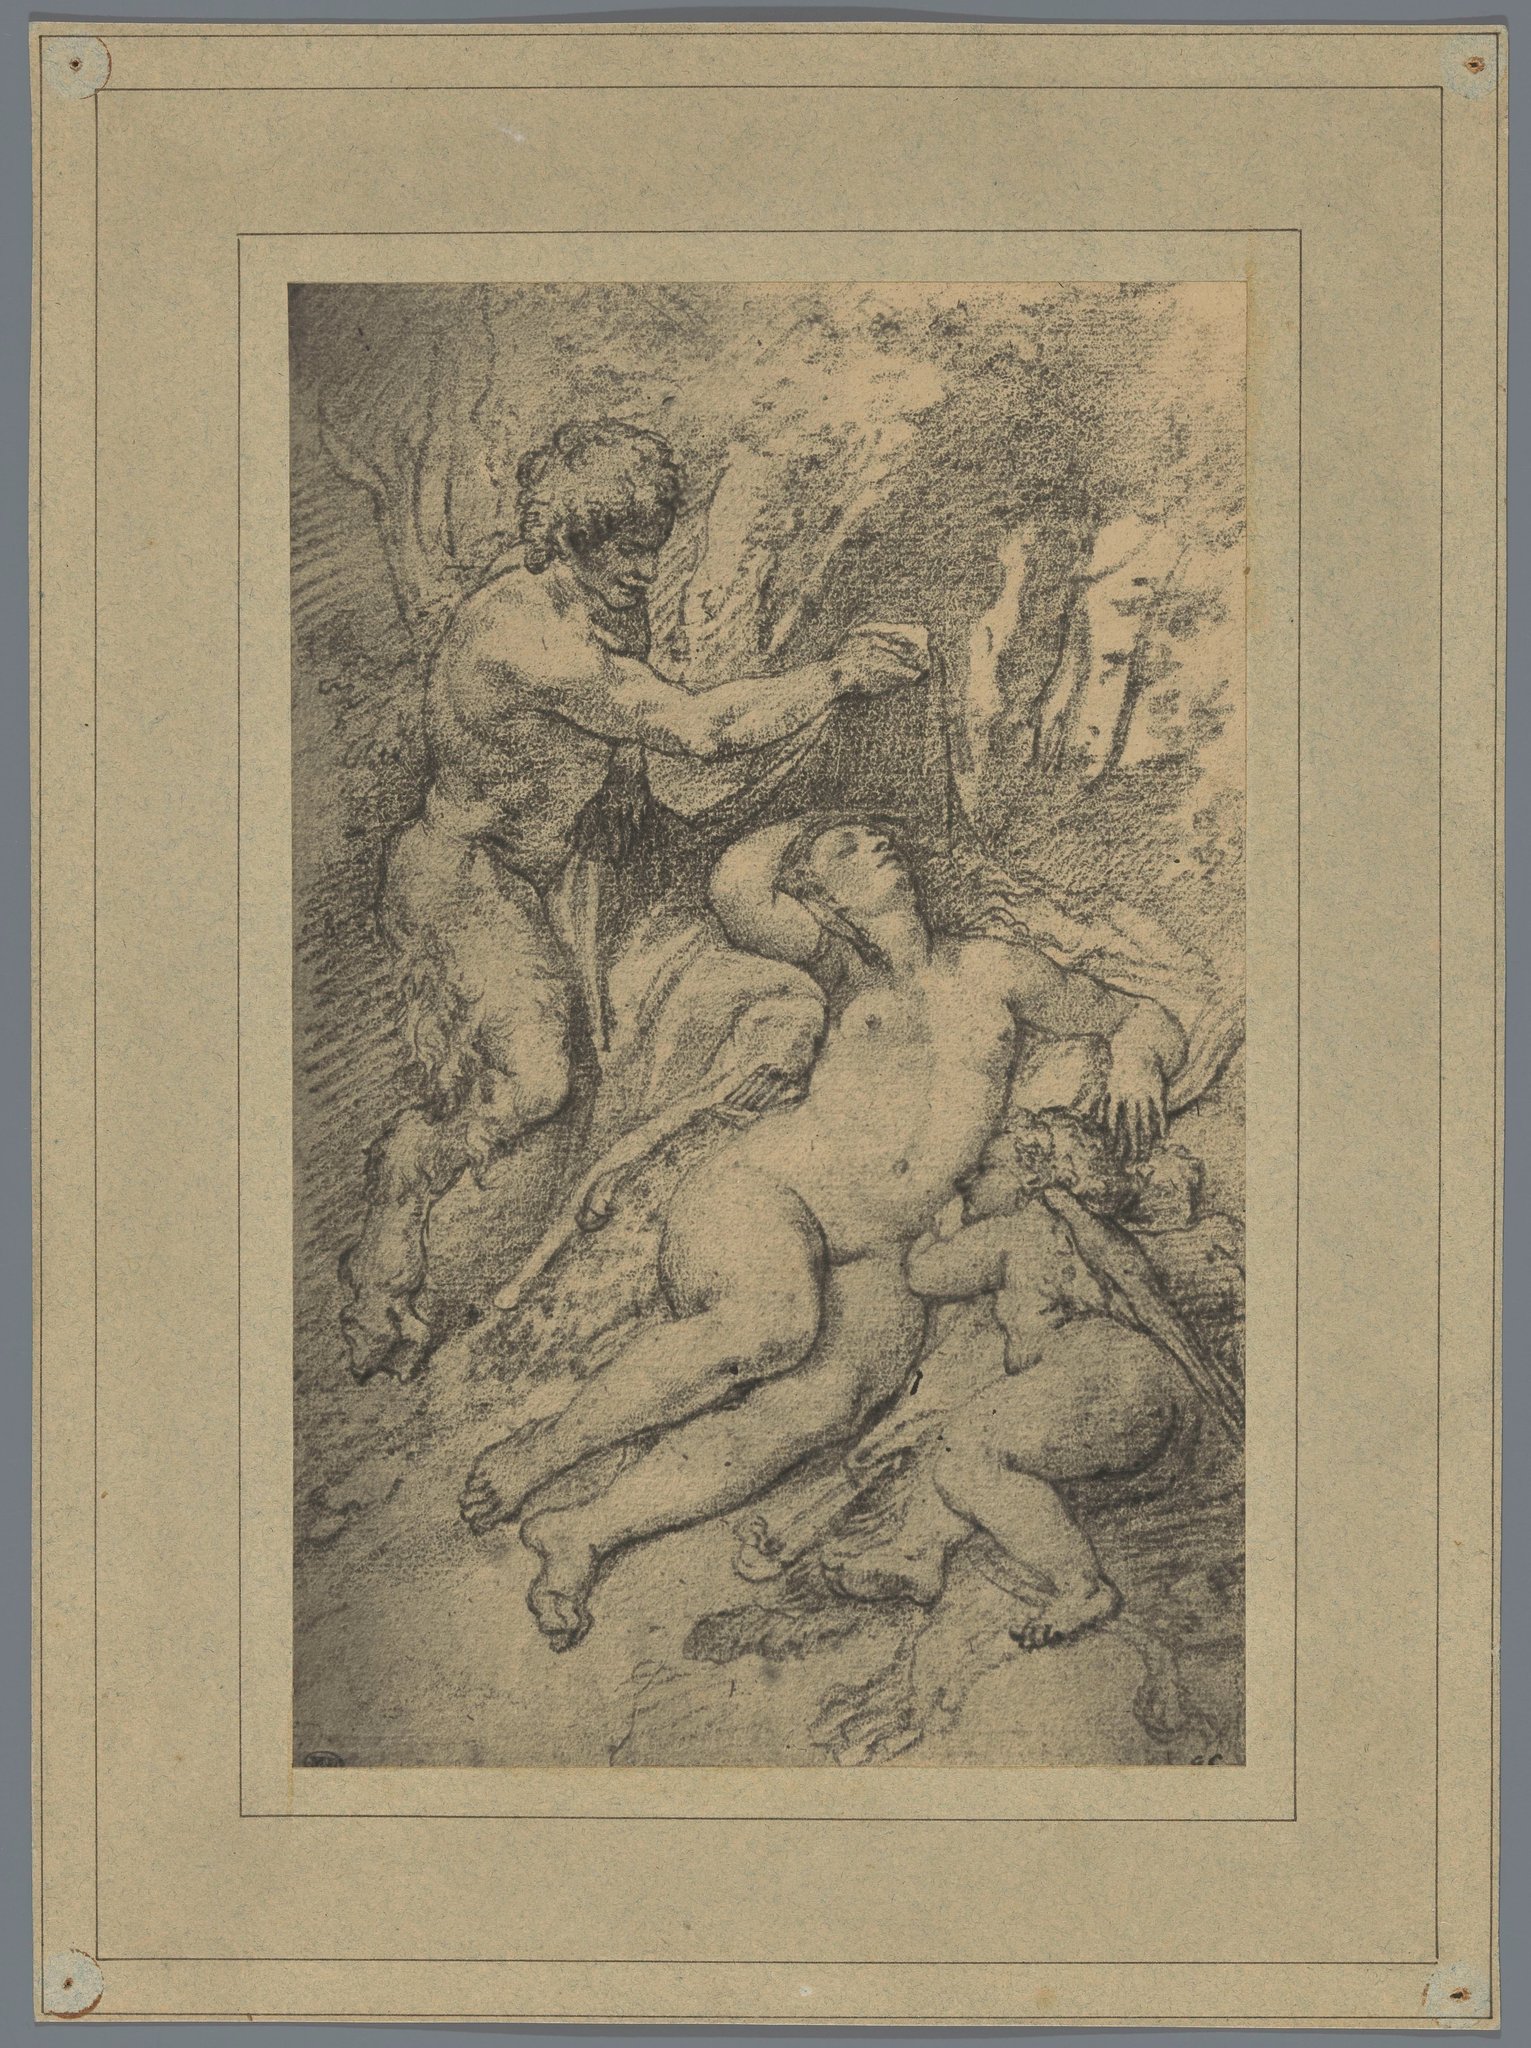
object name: photograph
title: Fotoreproductie van een tekening naar Venus en cupido met een sater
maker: Anonymous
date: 1850-1900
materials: cardboard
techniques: albumen print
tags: satyr(s) (in general), (story of) cupid, amor (eros), venus asleep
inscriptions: collector's mark: ‘Rijks normaalschool voor teekenonderwijzers Amsterdam’